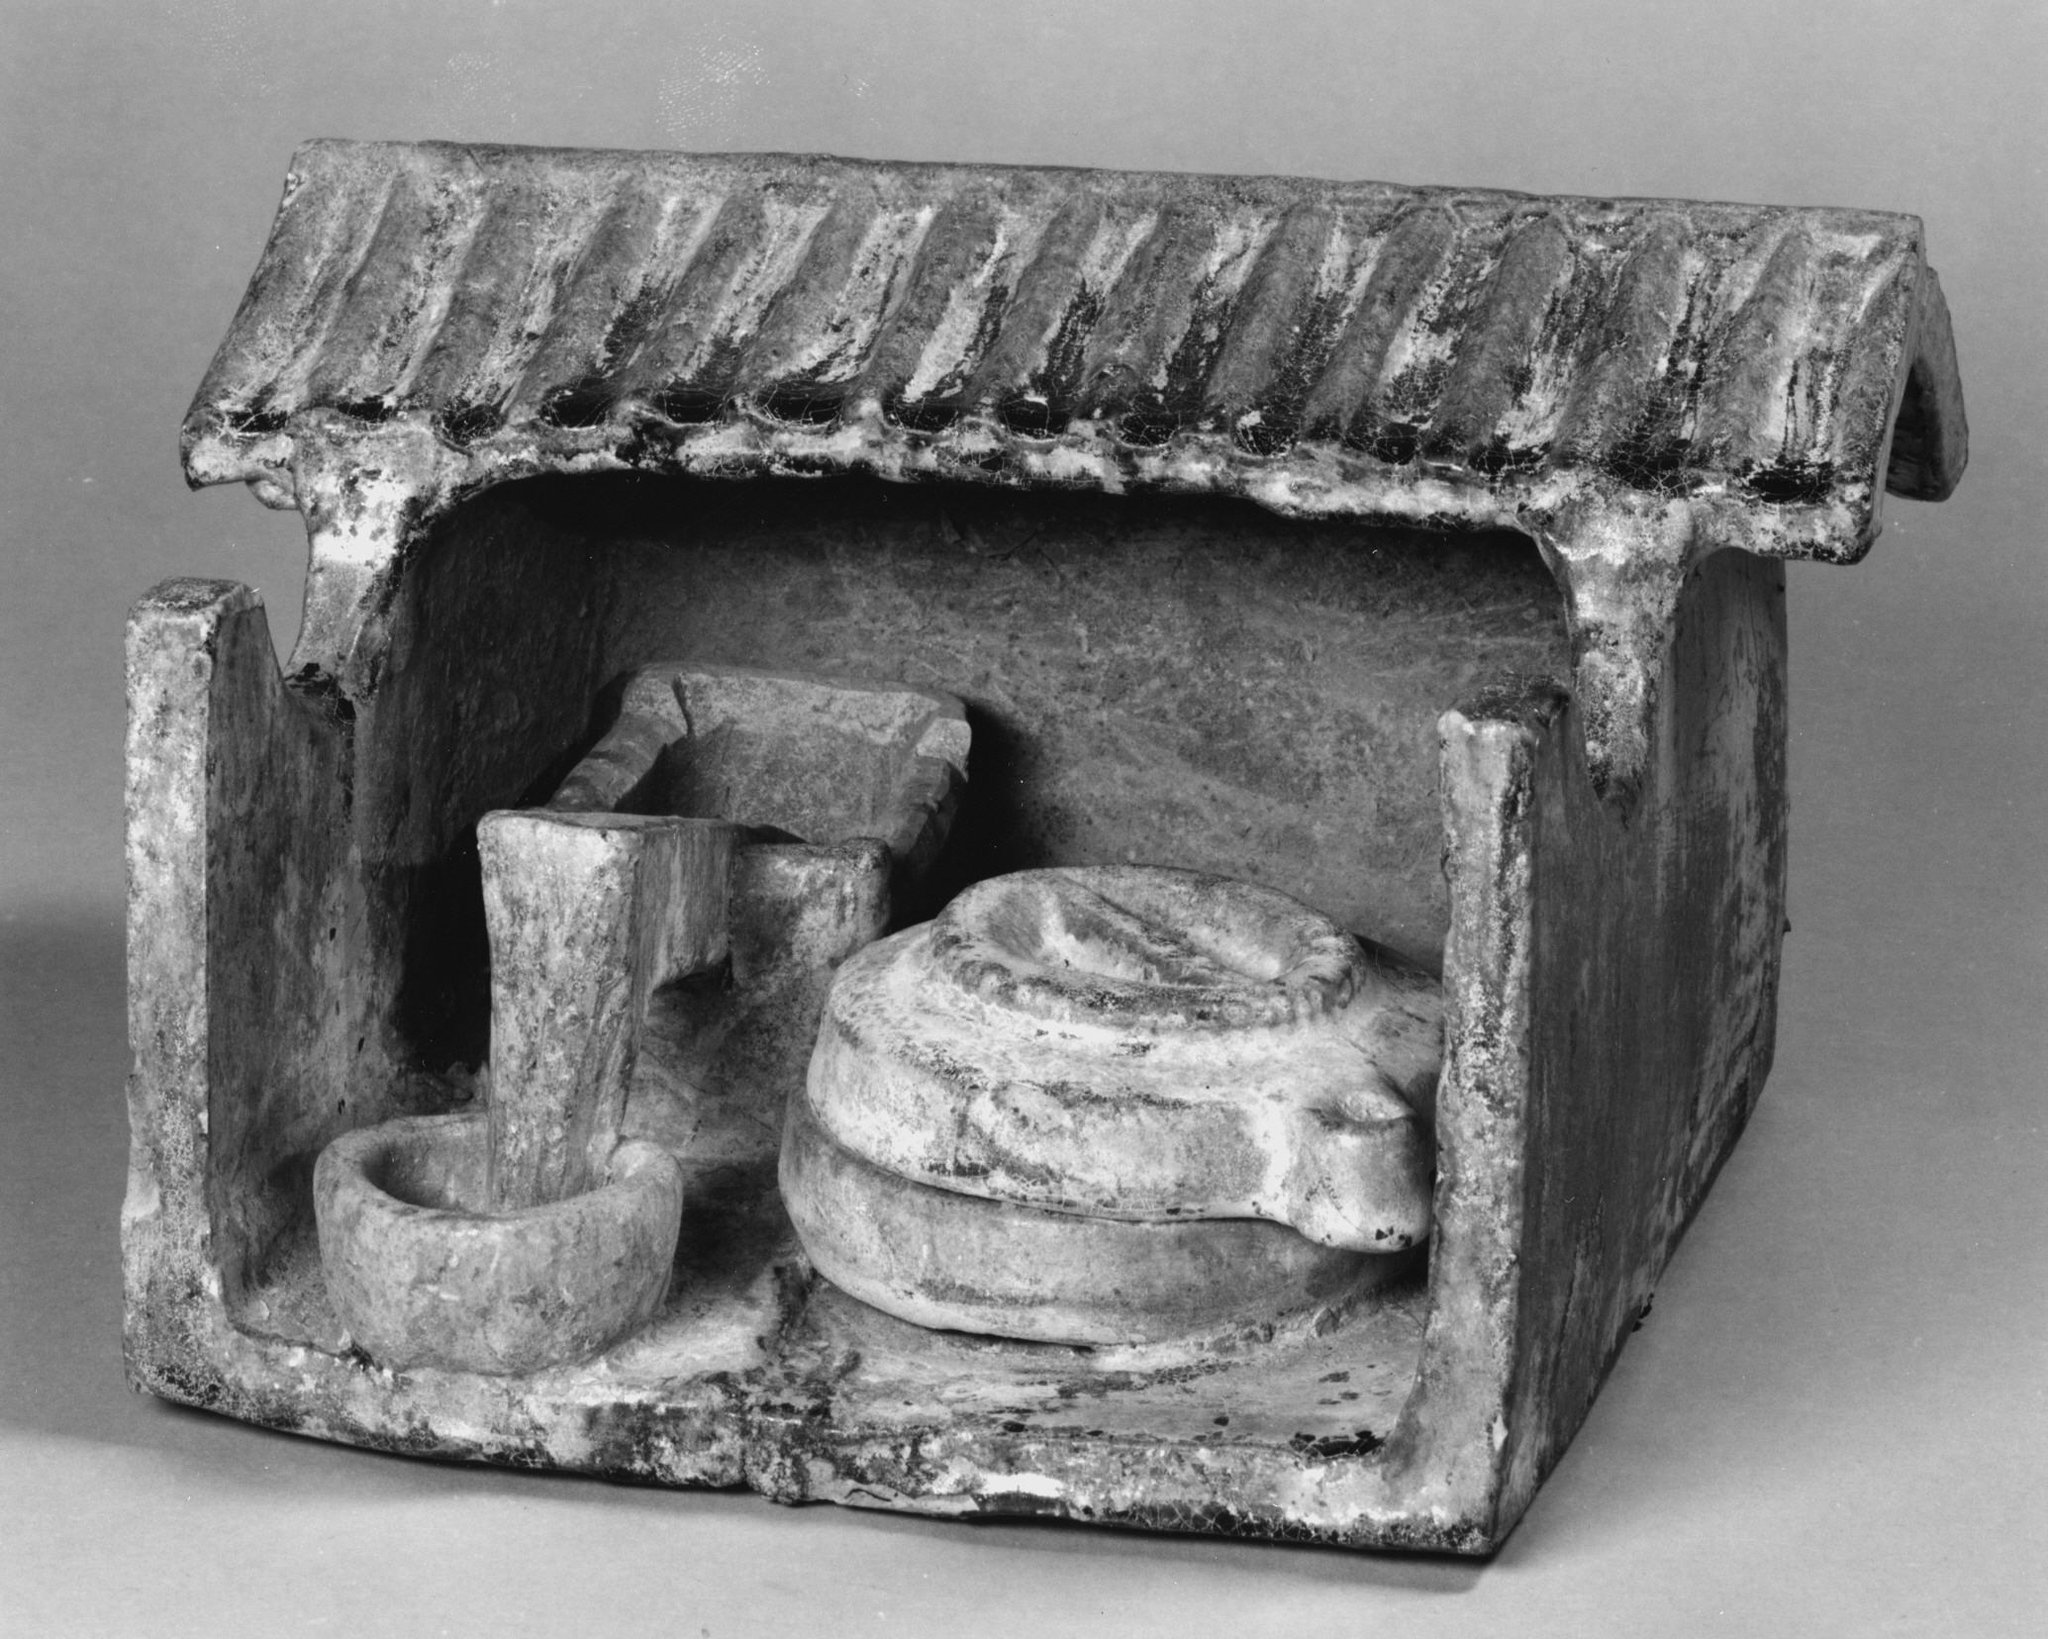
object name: architectural model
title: Mill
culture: chinese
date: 1-233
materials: earthenware, glaze